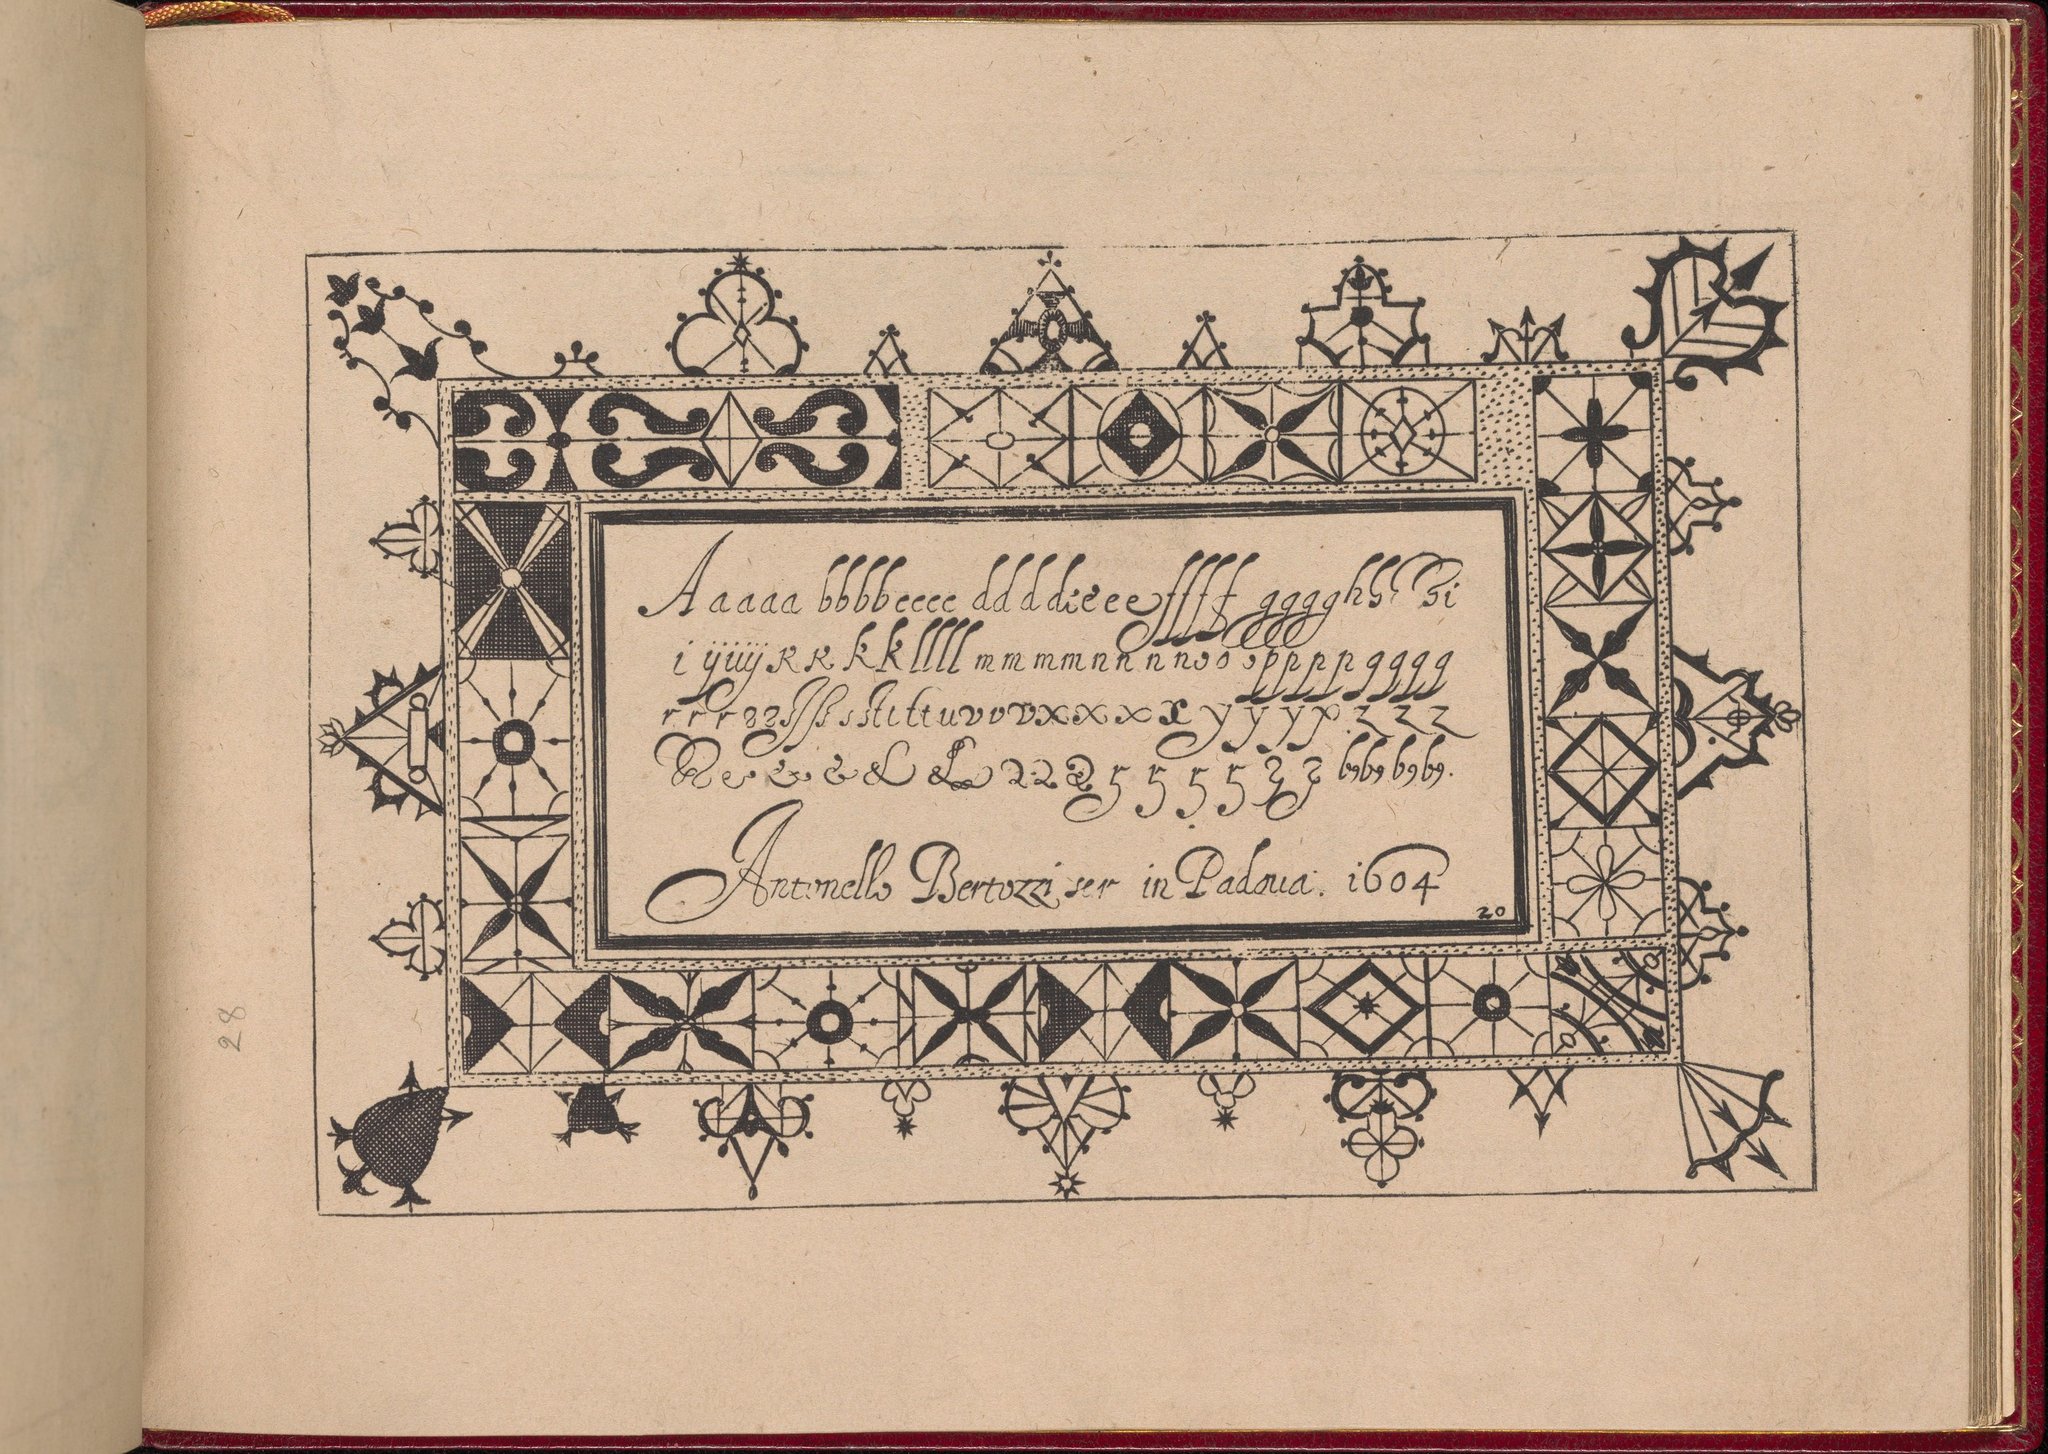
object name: book print ornament architecture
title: Ghirlanda: Di sei vaghi fiori scielti da piu famosi Giardini d'Italia, page 28 (recto)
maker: pietro paulo tozzi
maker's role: designer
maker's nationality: italian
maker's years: 1593-1628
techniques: drawing, etching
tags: ornament